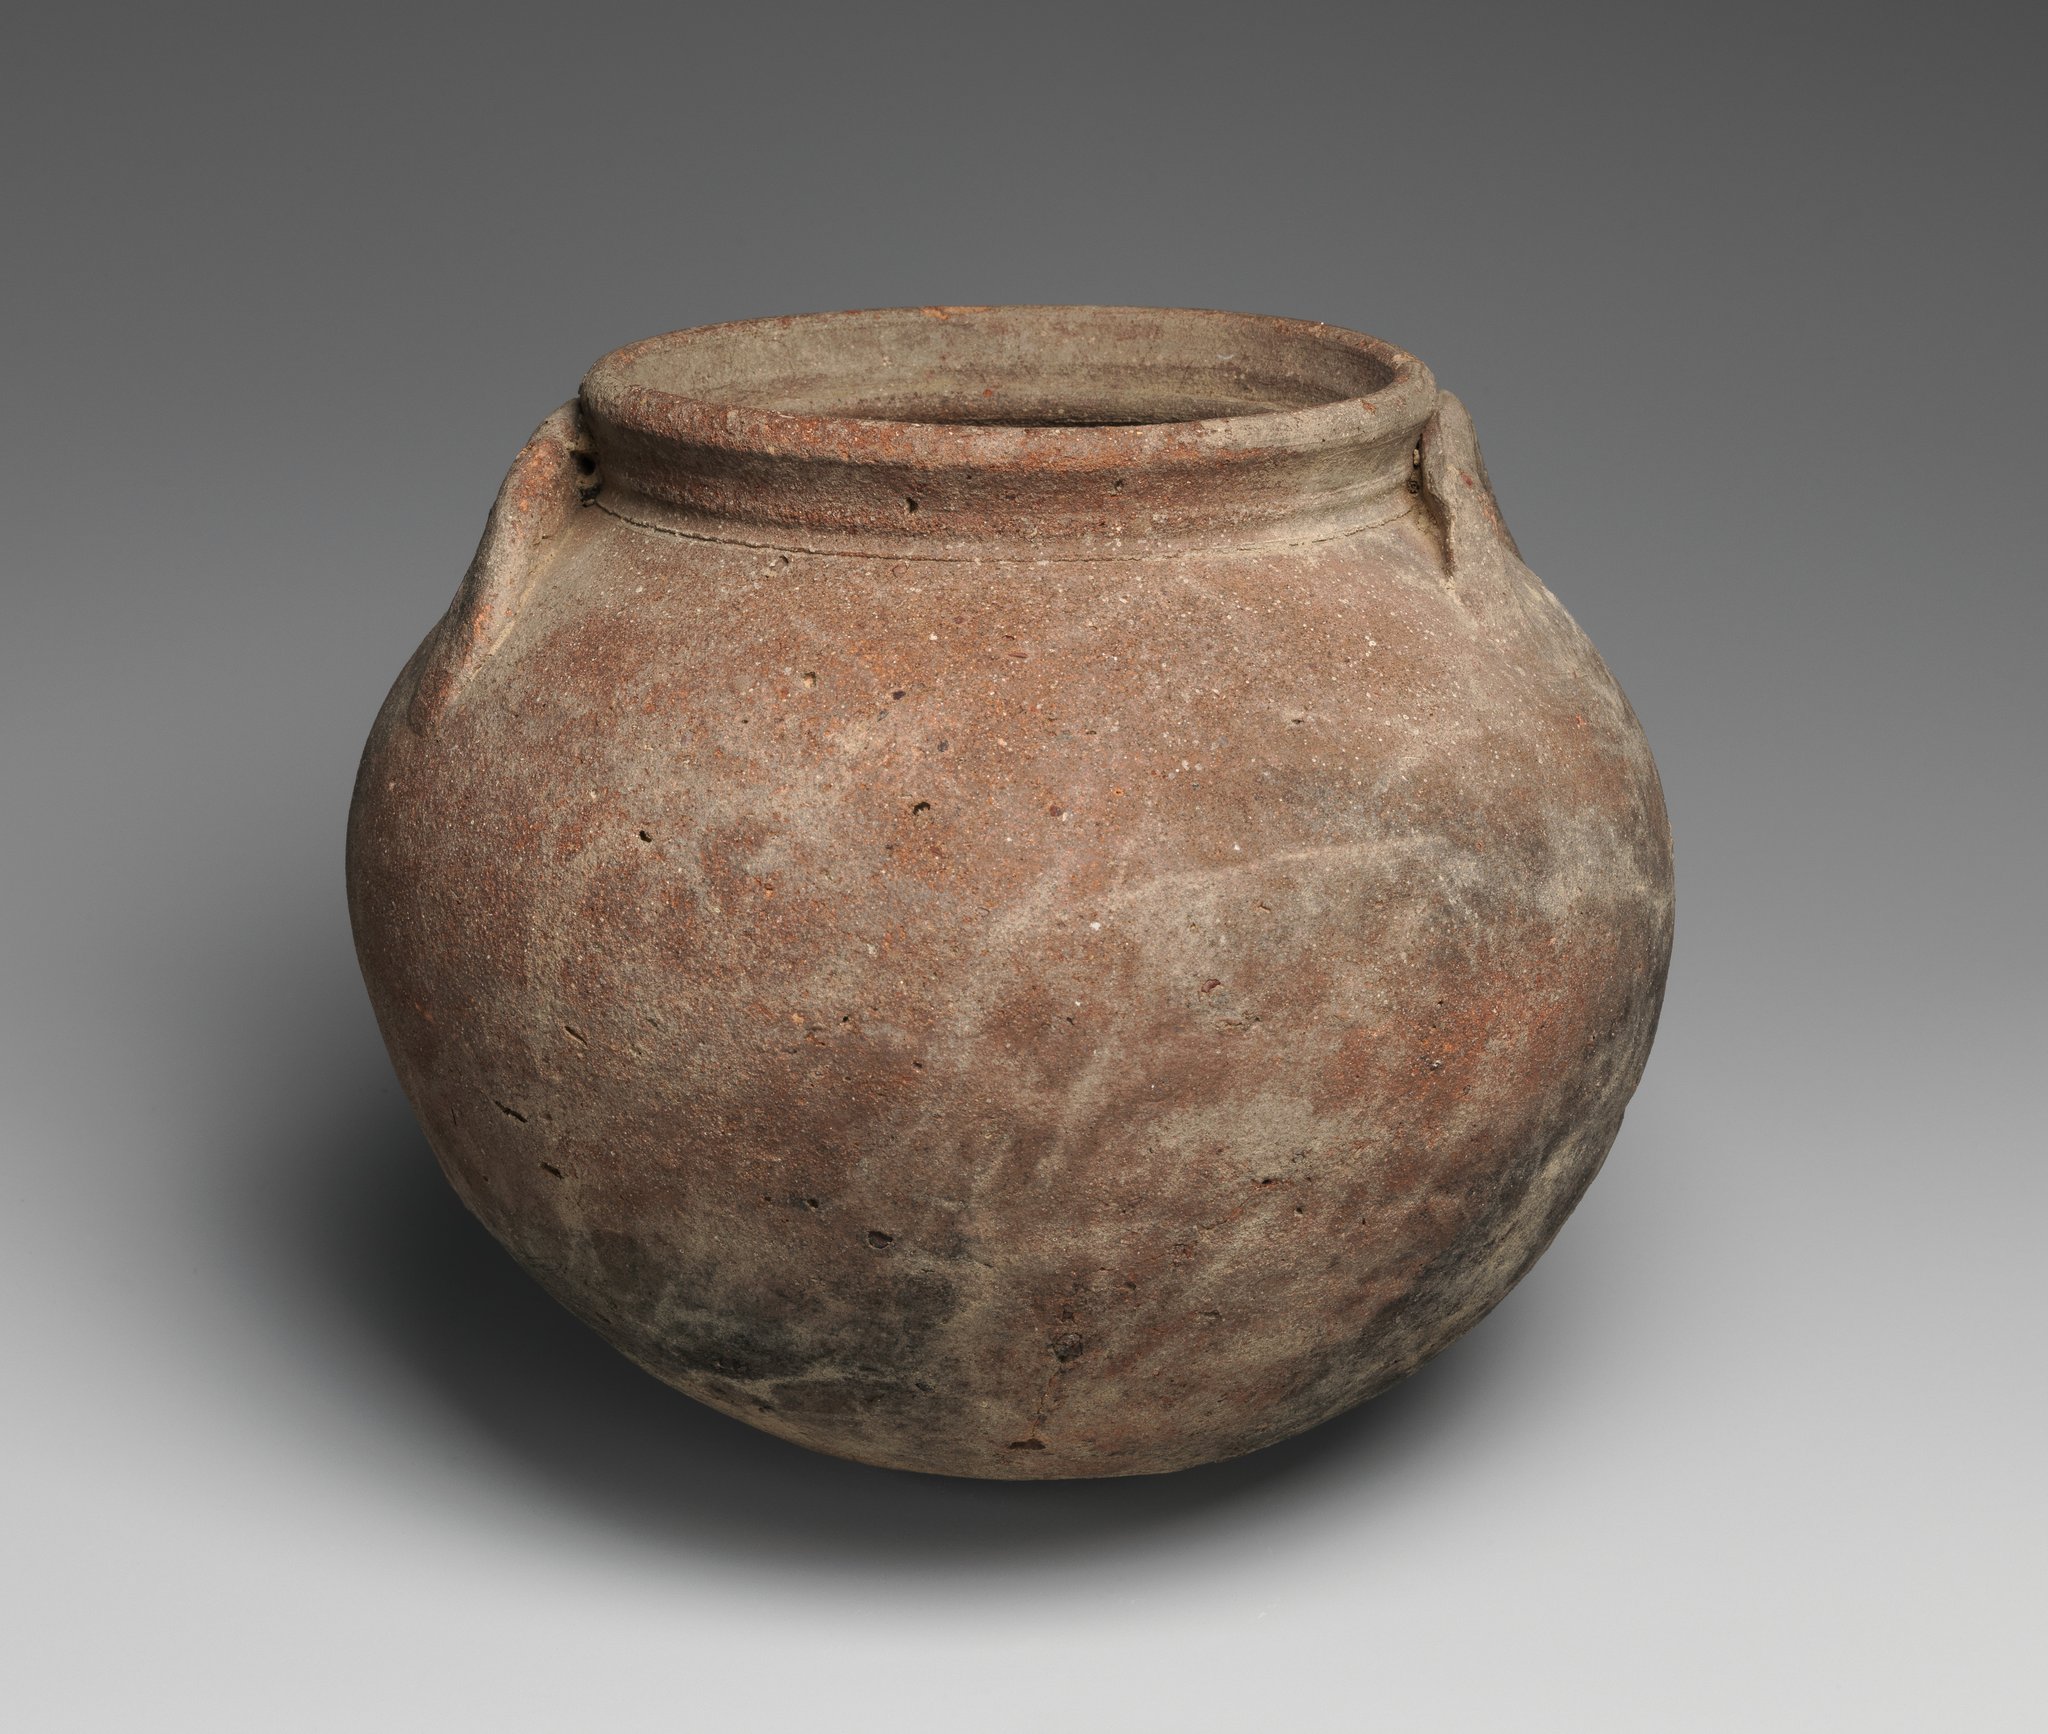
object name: pot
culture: coptic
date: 400 BCE-400 CE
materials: earthenware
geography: egypt